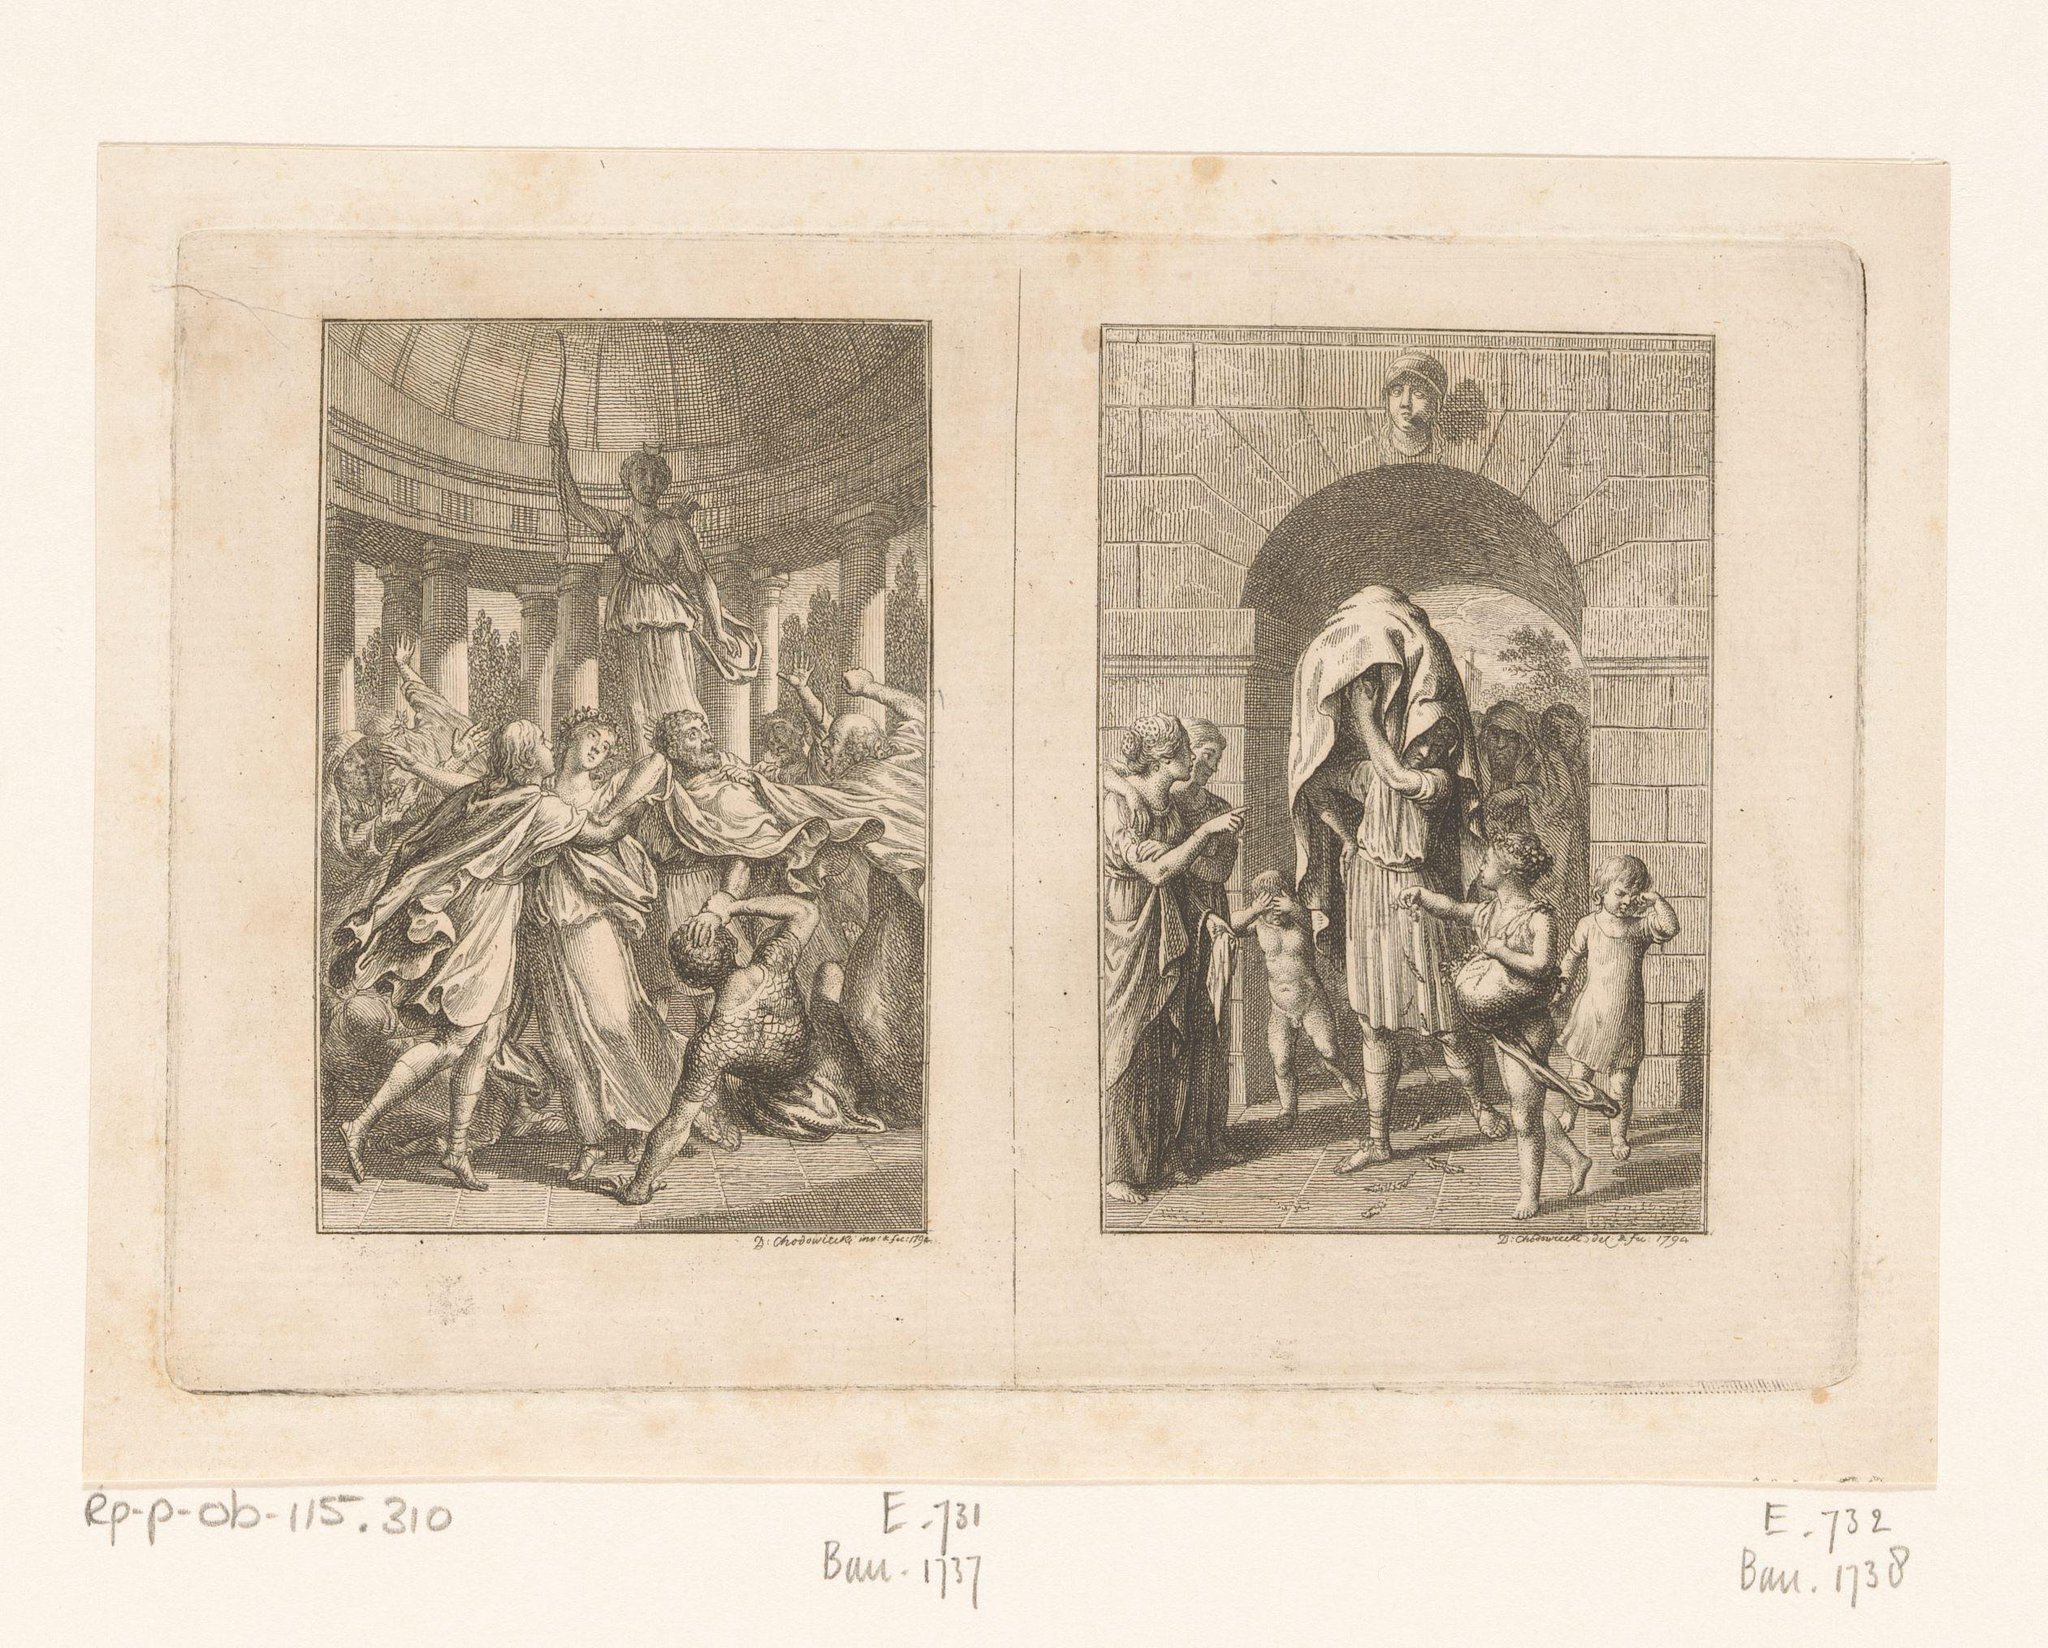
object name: print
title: Twee voorstellingen uit het leven van Theseus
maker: daniel nikolaus chodowiecki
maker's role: draughtsman, print maker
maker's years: 1726-1801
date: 1794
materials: paper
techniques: etching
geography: berlin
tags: theseus and pirithous abducting helen, cimon, the athenian, brings theseus' bones back to his city, (story of) theseus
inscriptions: collector's mark: Lugt 2228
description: Latere staat gebruikt voor: Becker, Wilhelm Gottlieb. Taschenbuch und Almanach zum geselligen Vernügen von W. G. Becker für 1795. Leipzig: Voss und Companie, s.a.